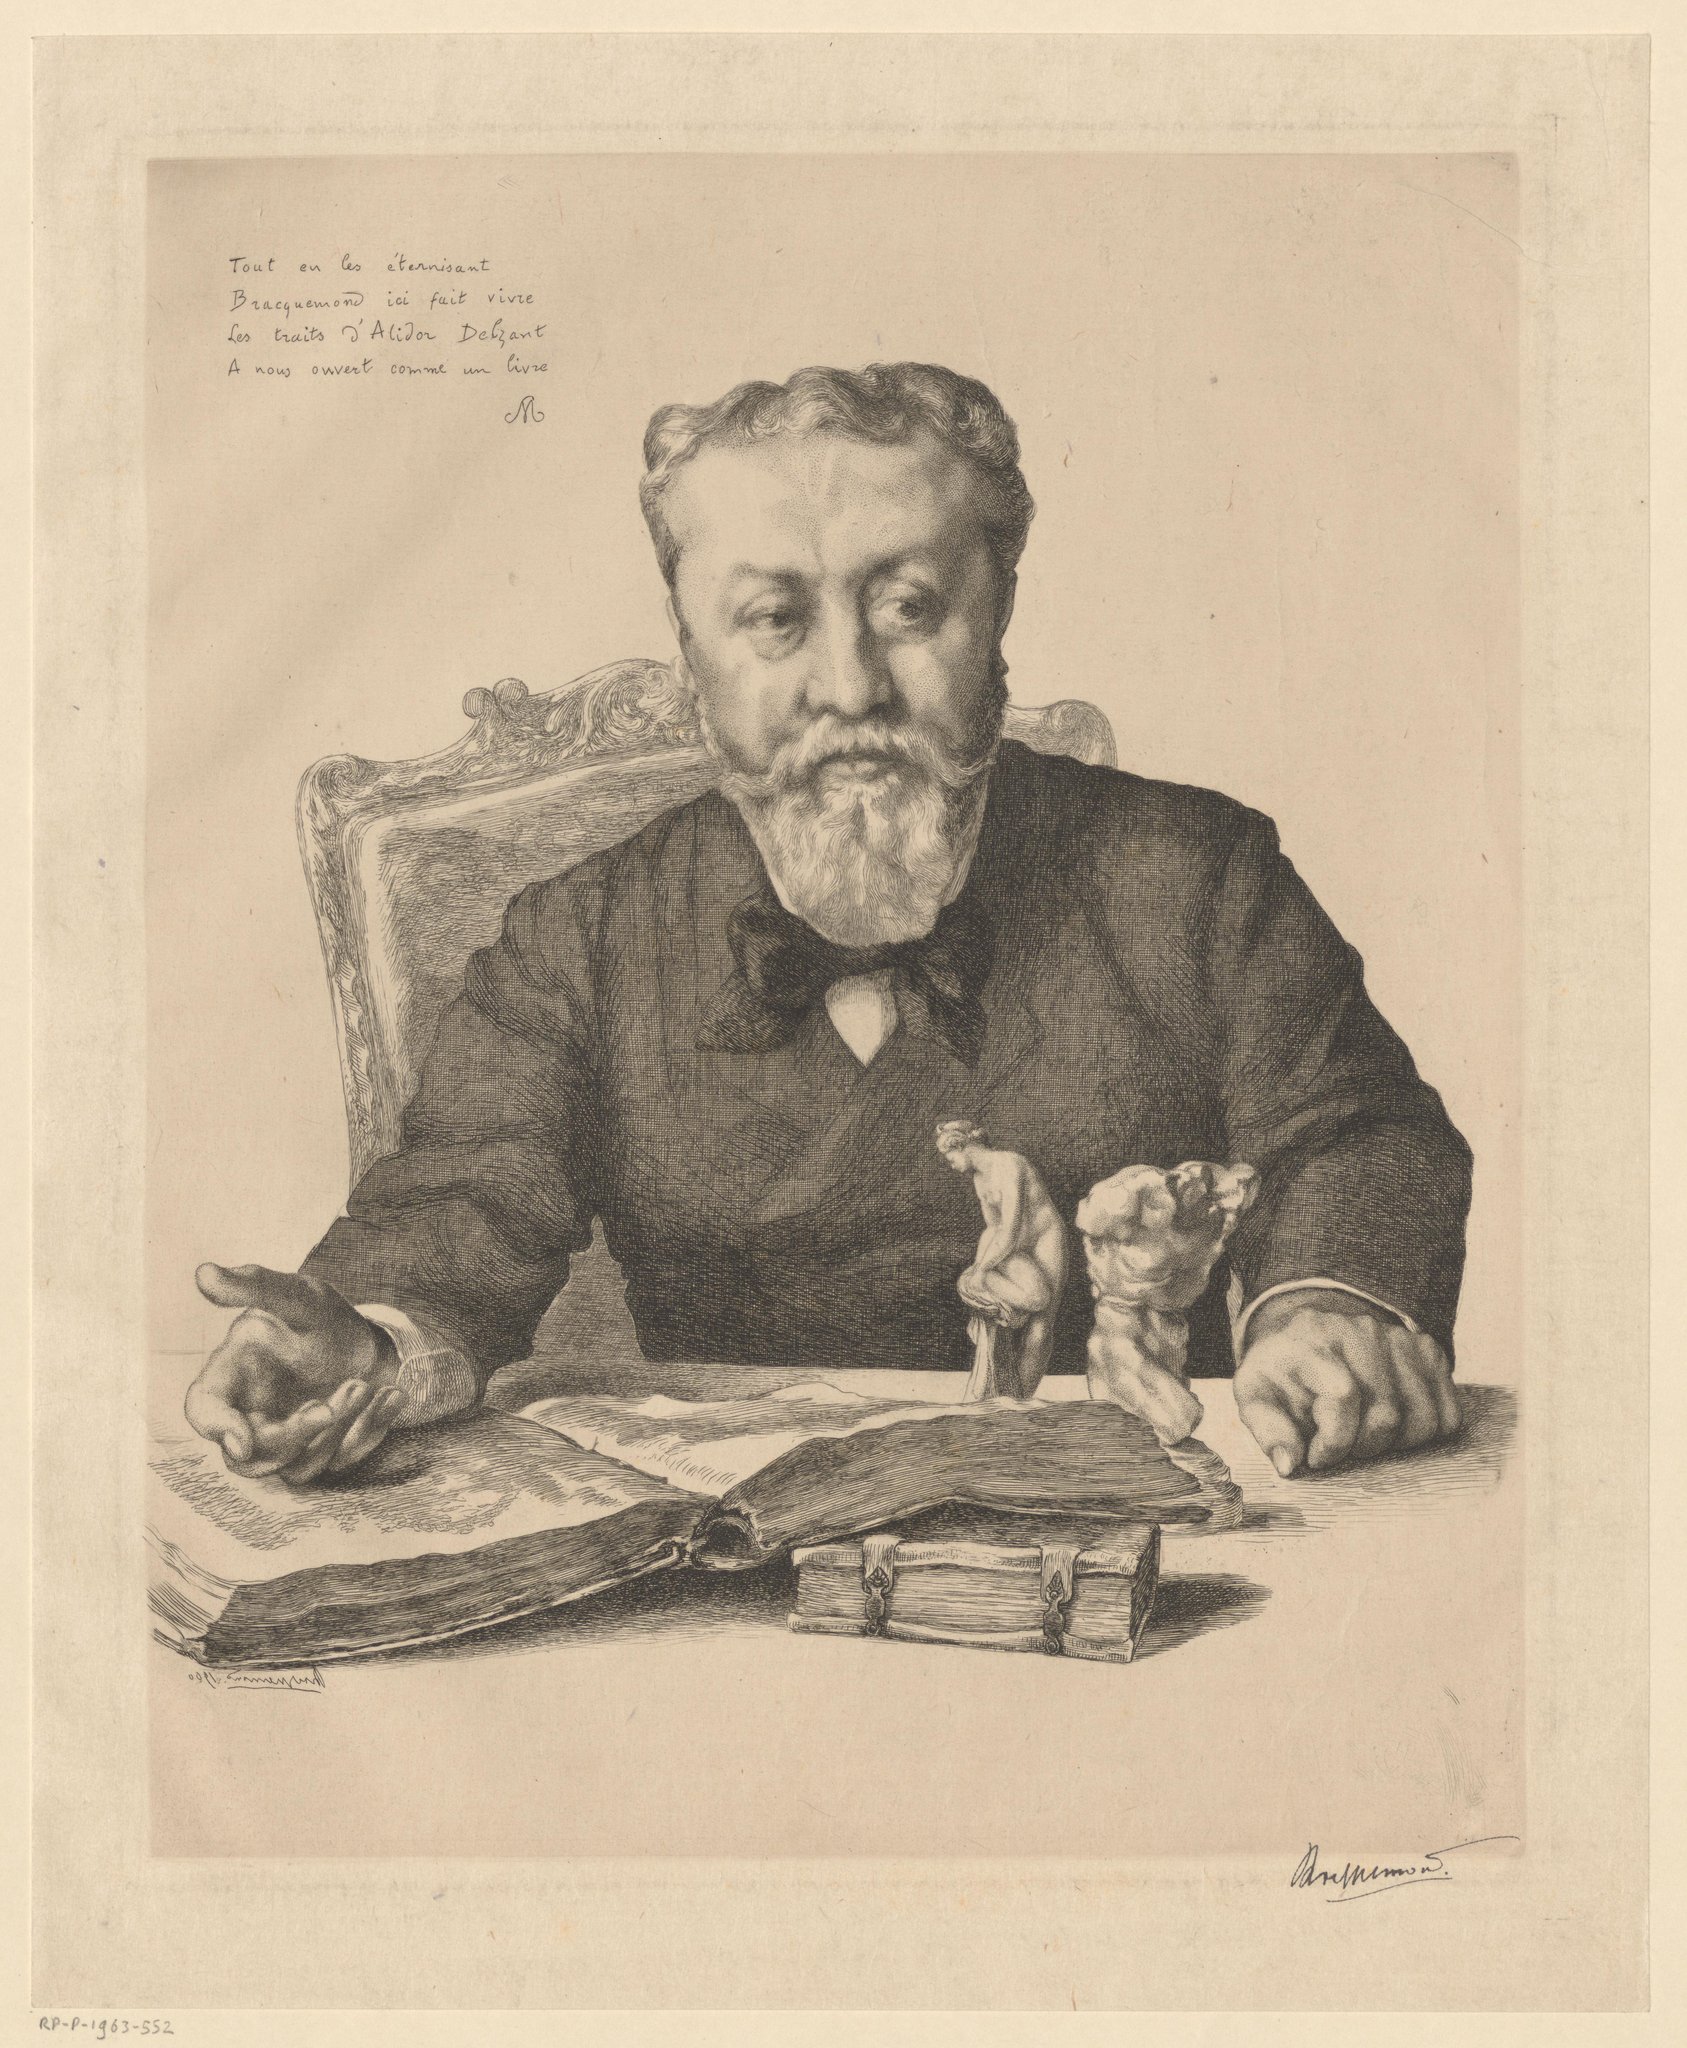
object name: print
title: Portret van Alidor Delzant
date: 1900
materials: paper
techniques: engraving, etching, intaglio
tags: alidor delzant, historical persons, portrait of a writer, book, sculpture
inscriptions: monogram: ‘M’, collector's mark: Lugt 2228